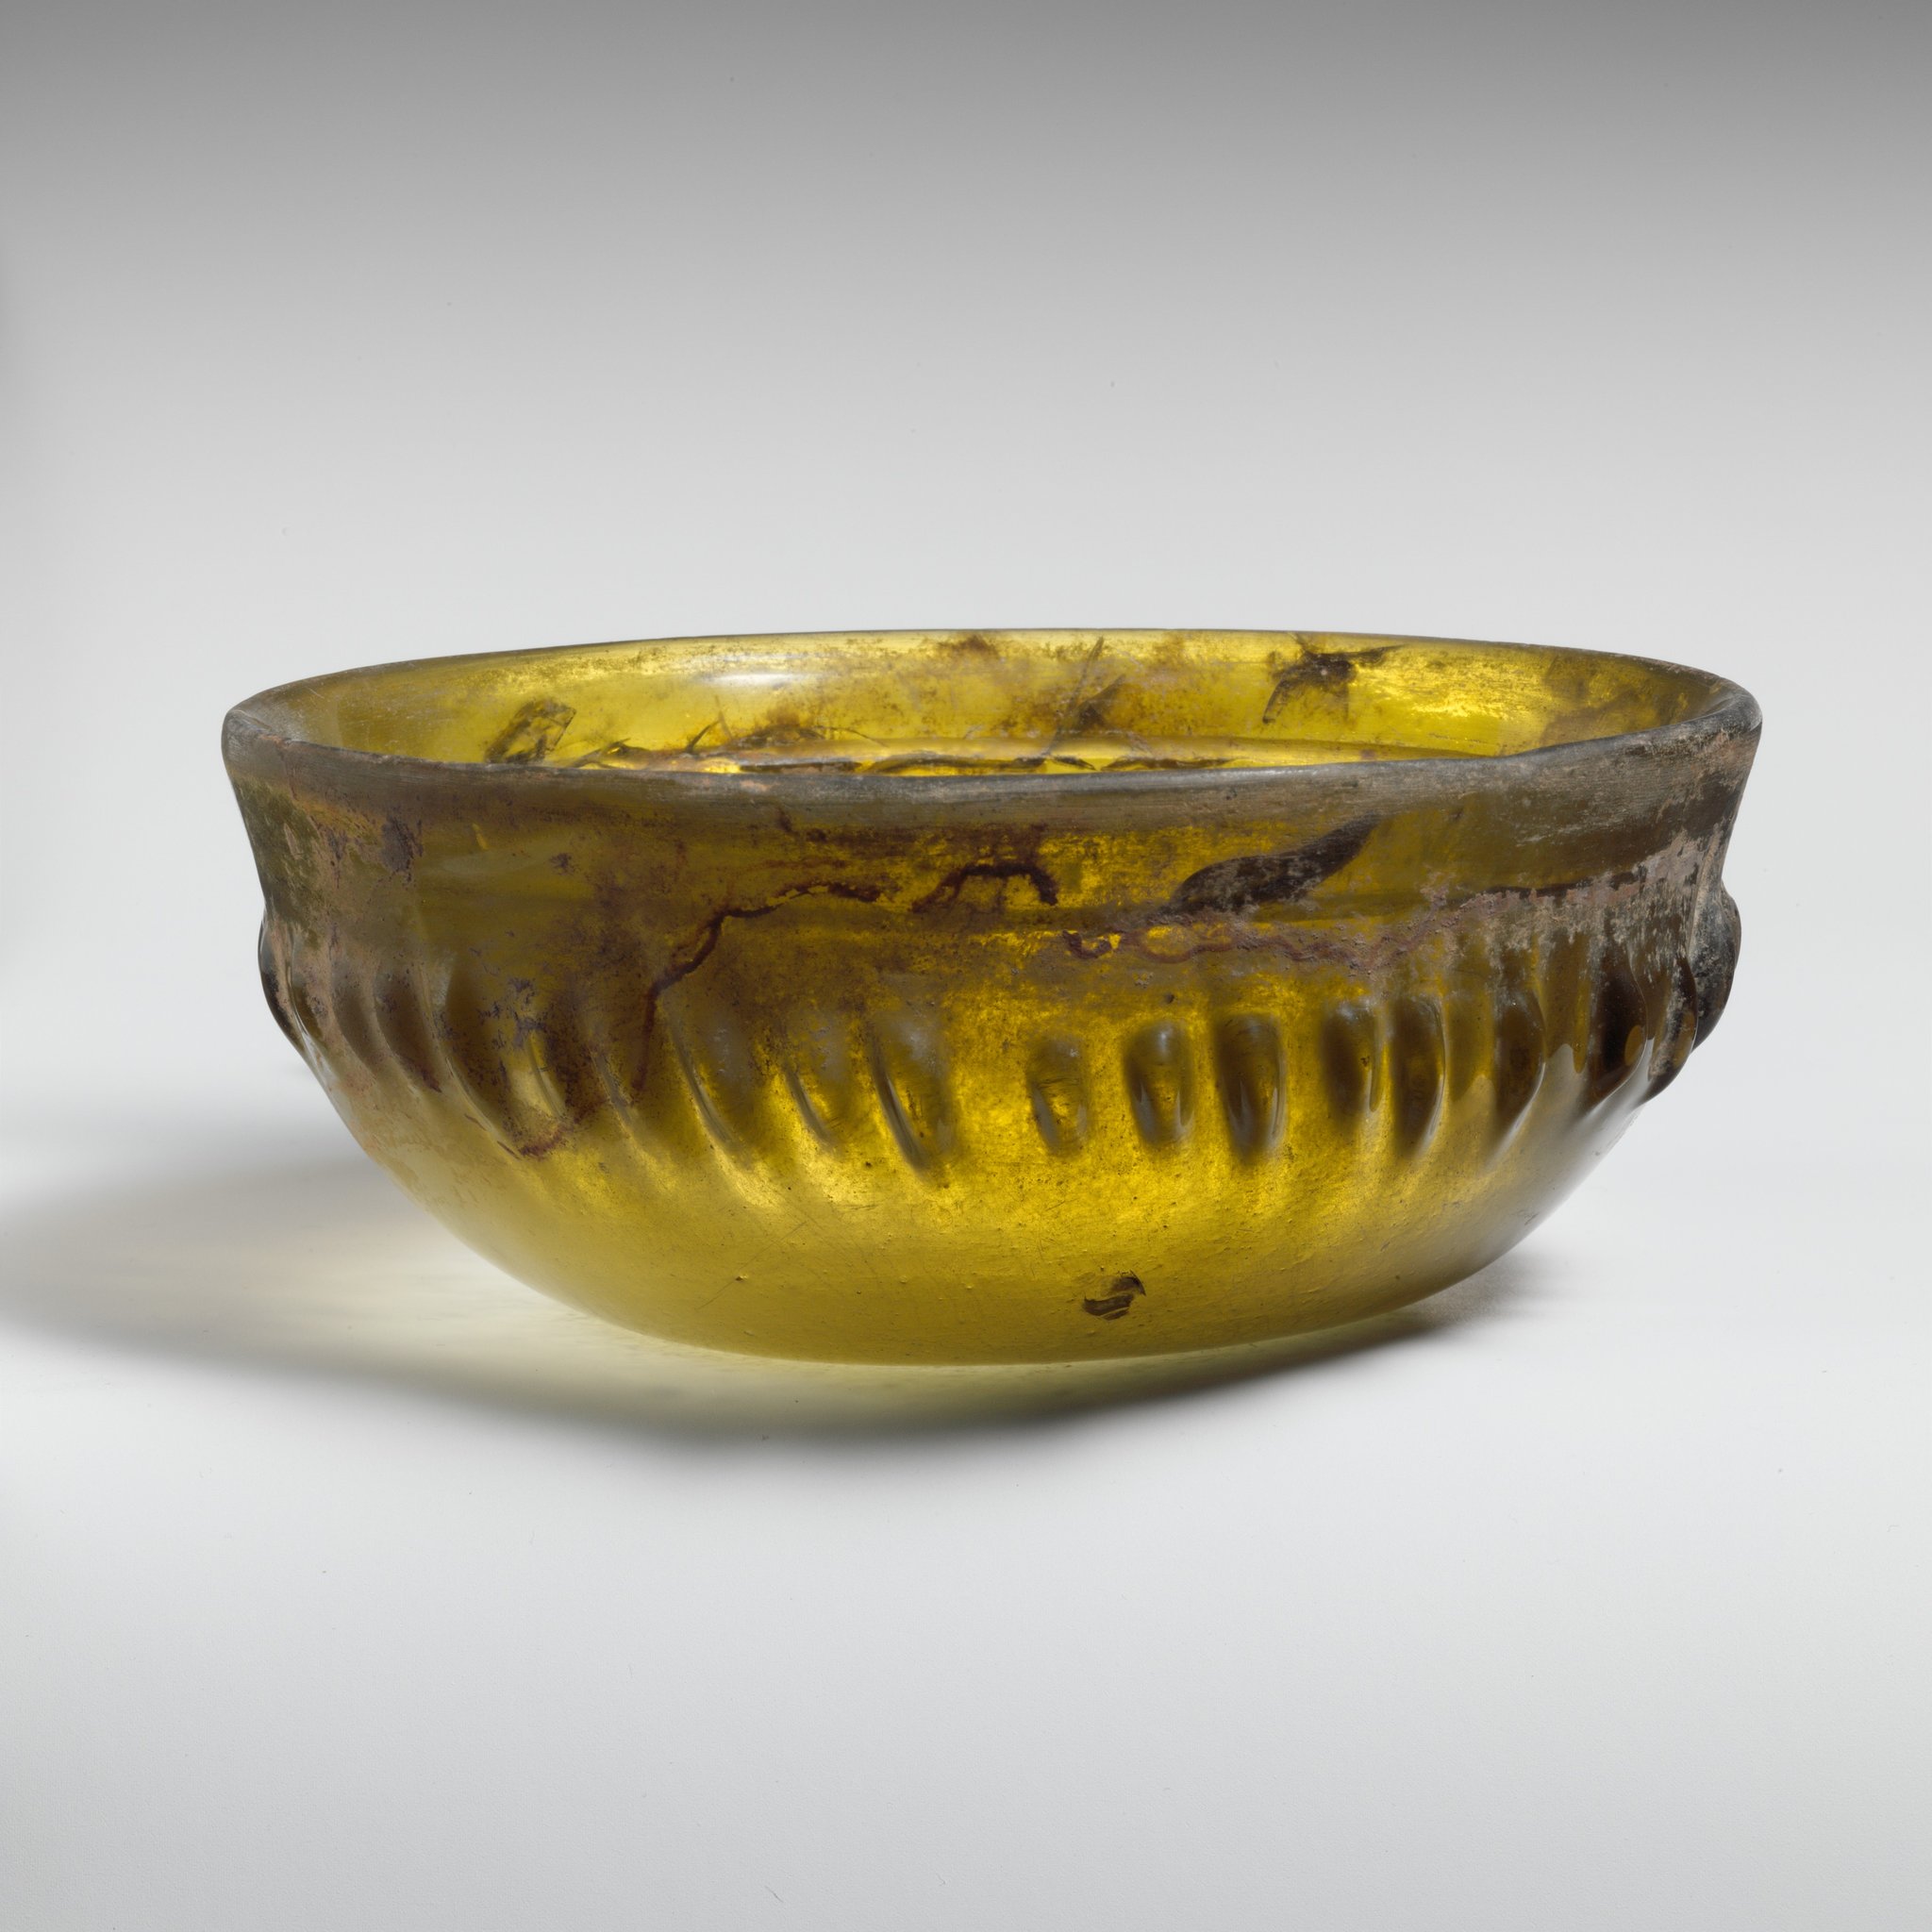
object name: bowl, ribbed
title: Glass ribbed bowl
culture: greek, eastern mediterranean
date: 100-1 BCE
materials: glass